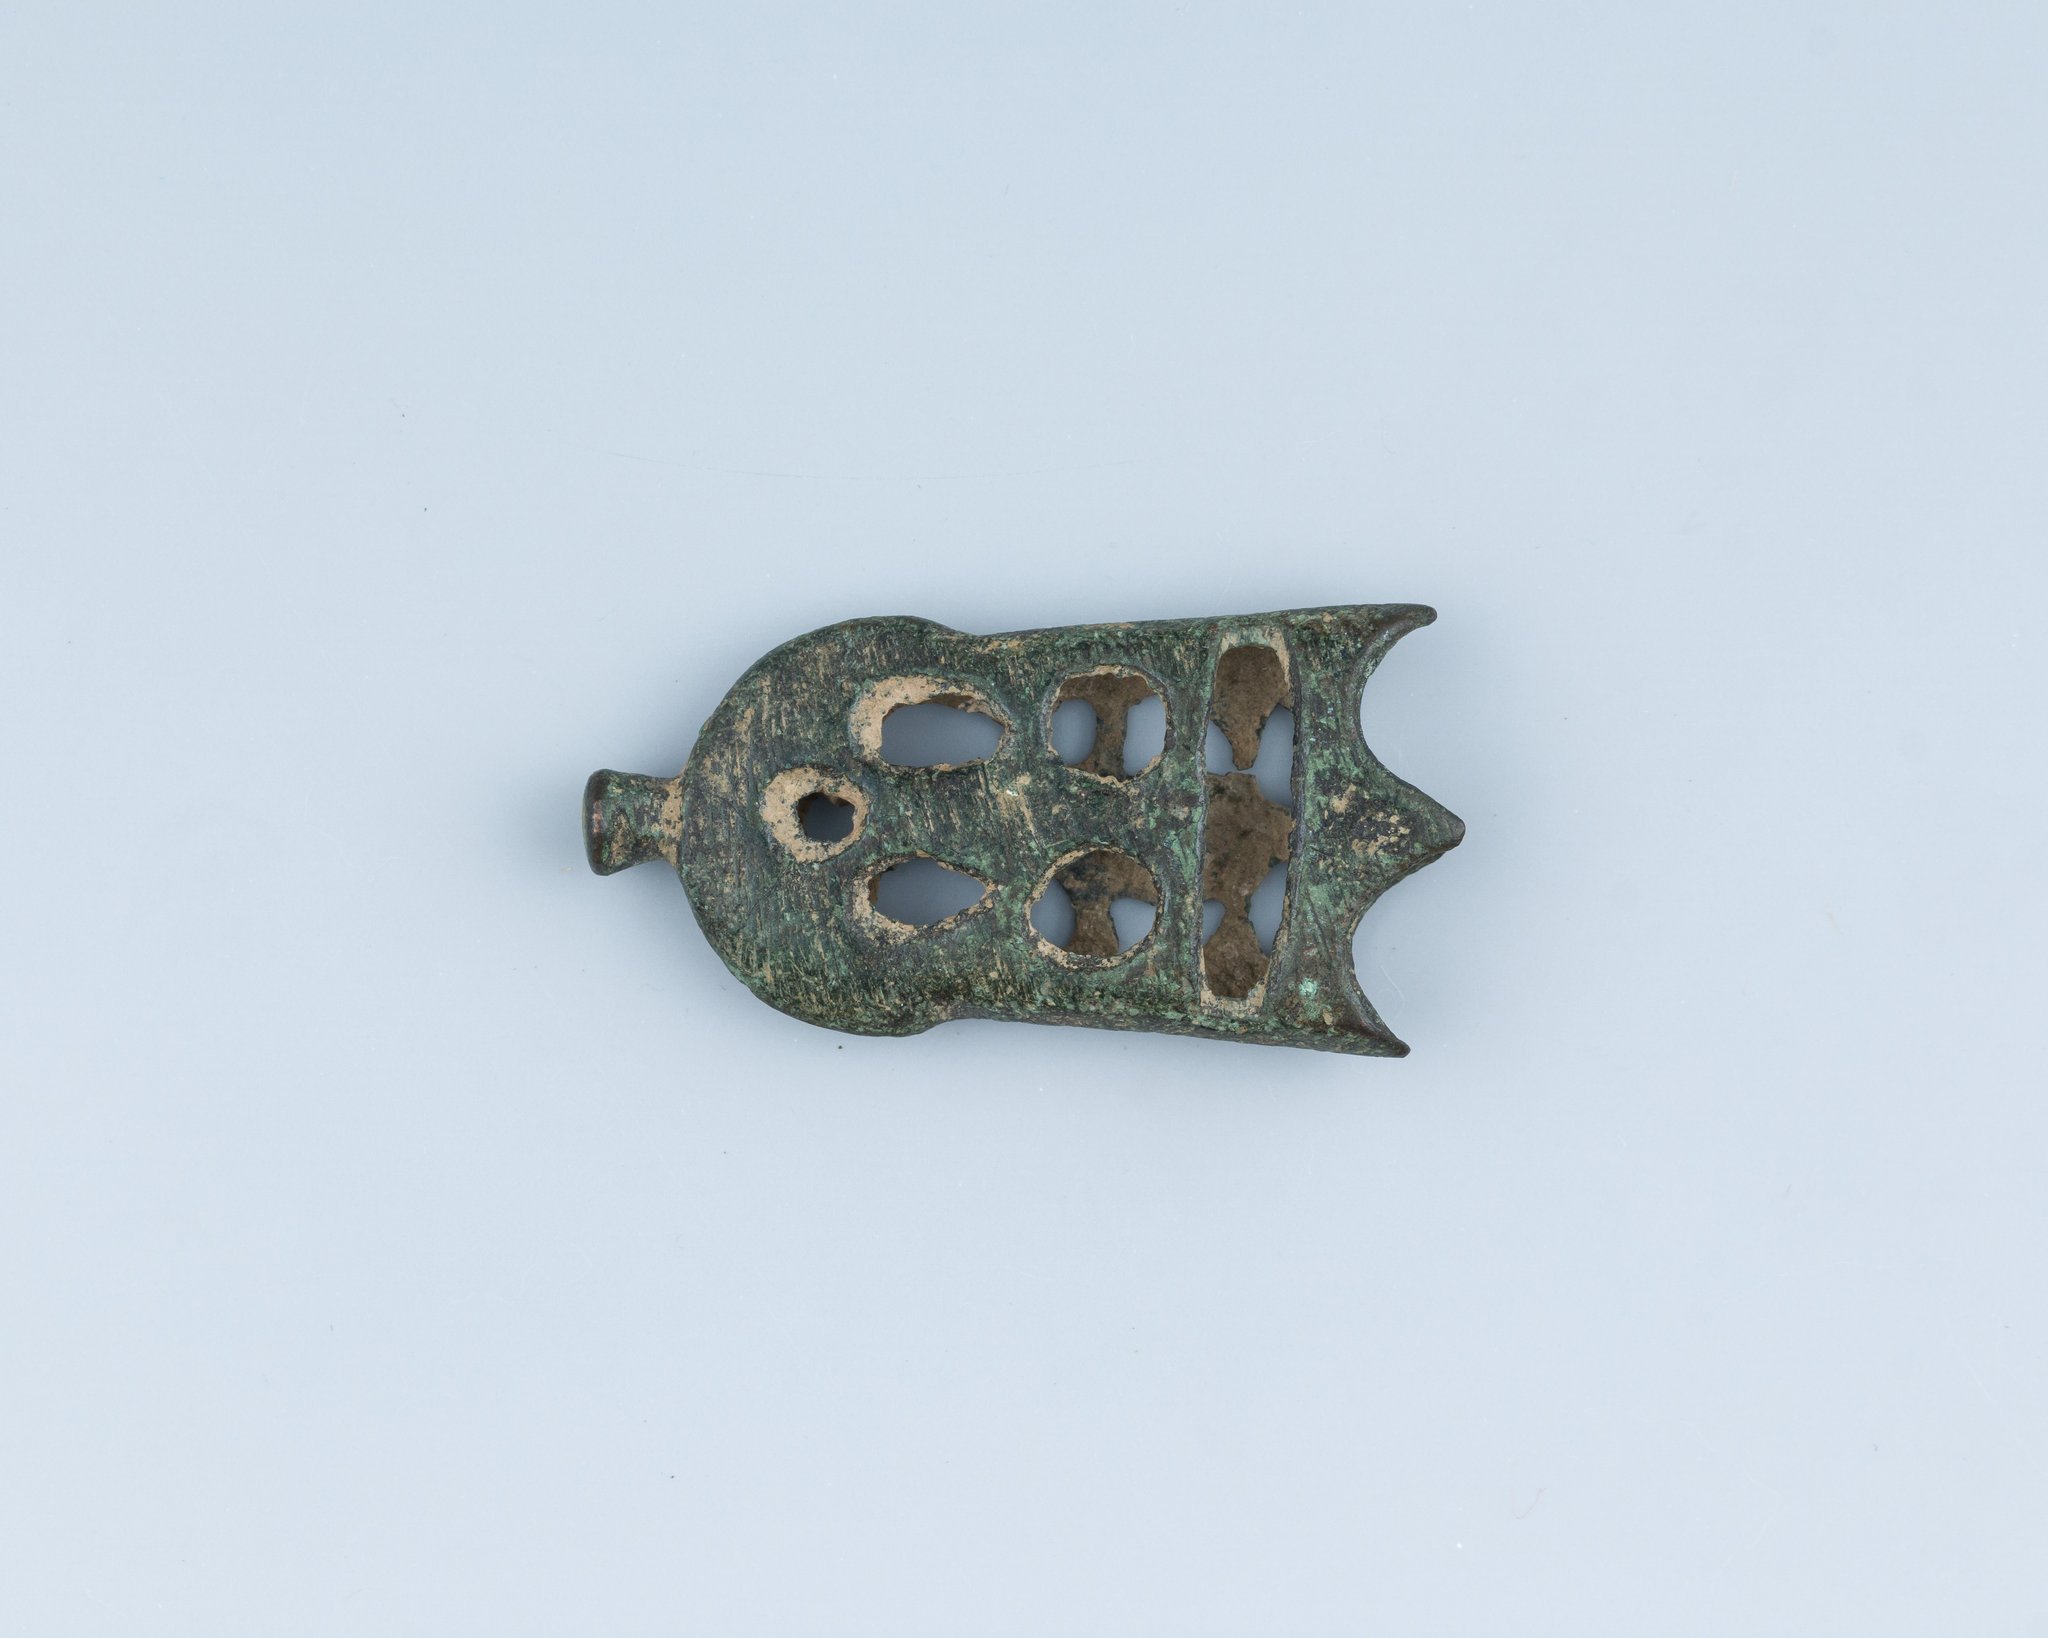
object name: mordant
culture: european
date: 1401-1700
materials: bronze